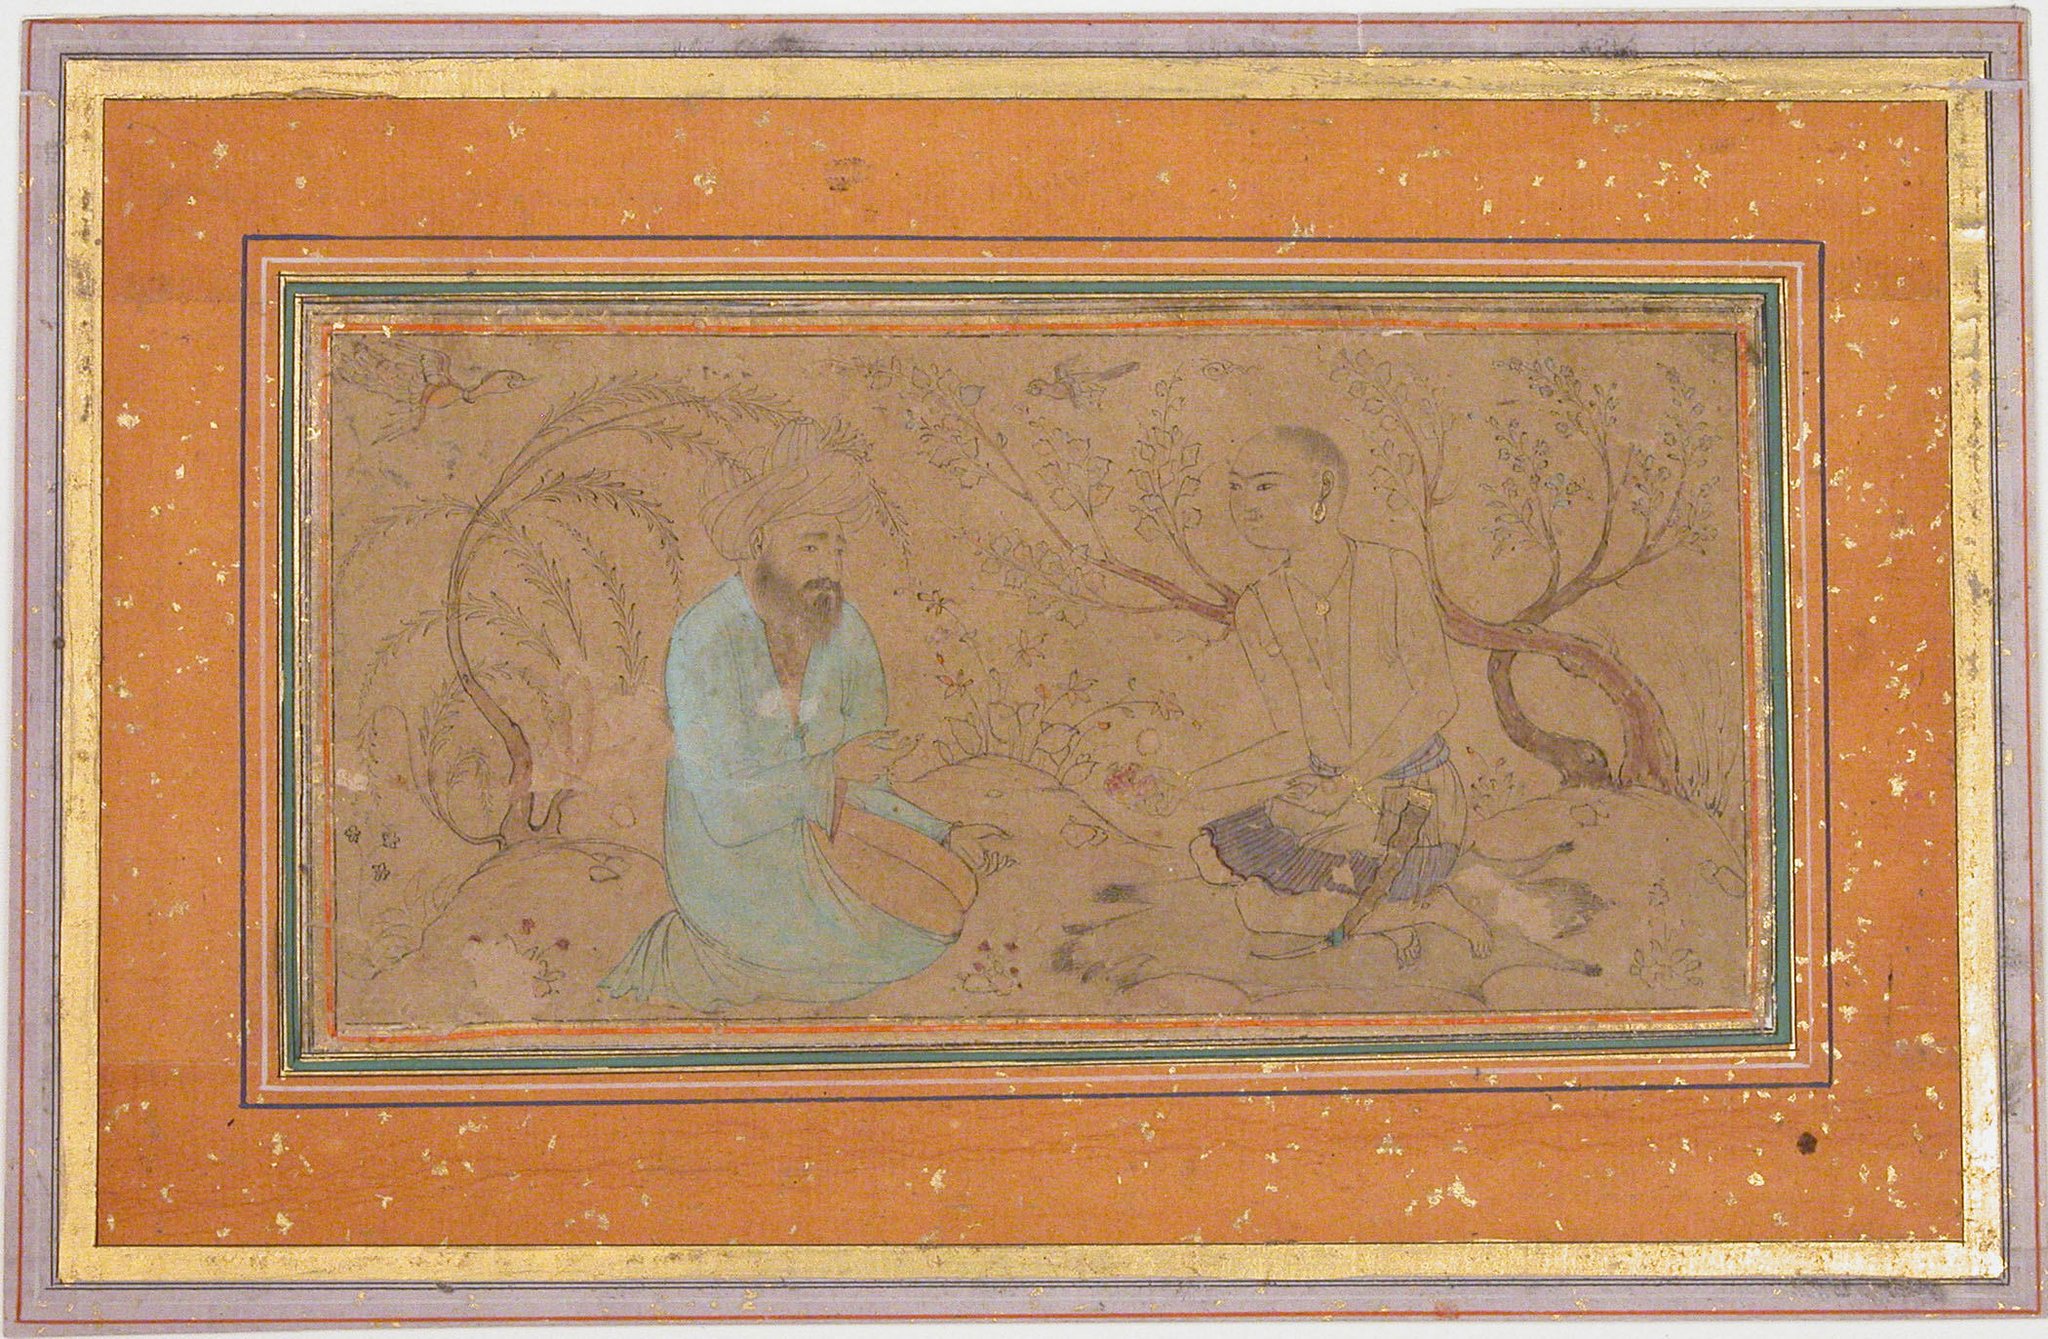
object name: illustrated single work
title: Visit to a Hermit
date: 1601-1700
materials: gold, ink, paper, watercolor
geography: iran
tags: birds,men,trees